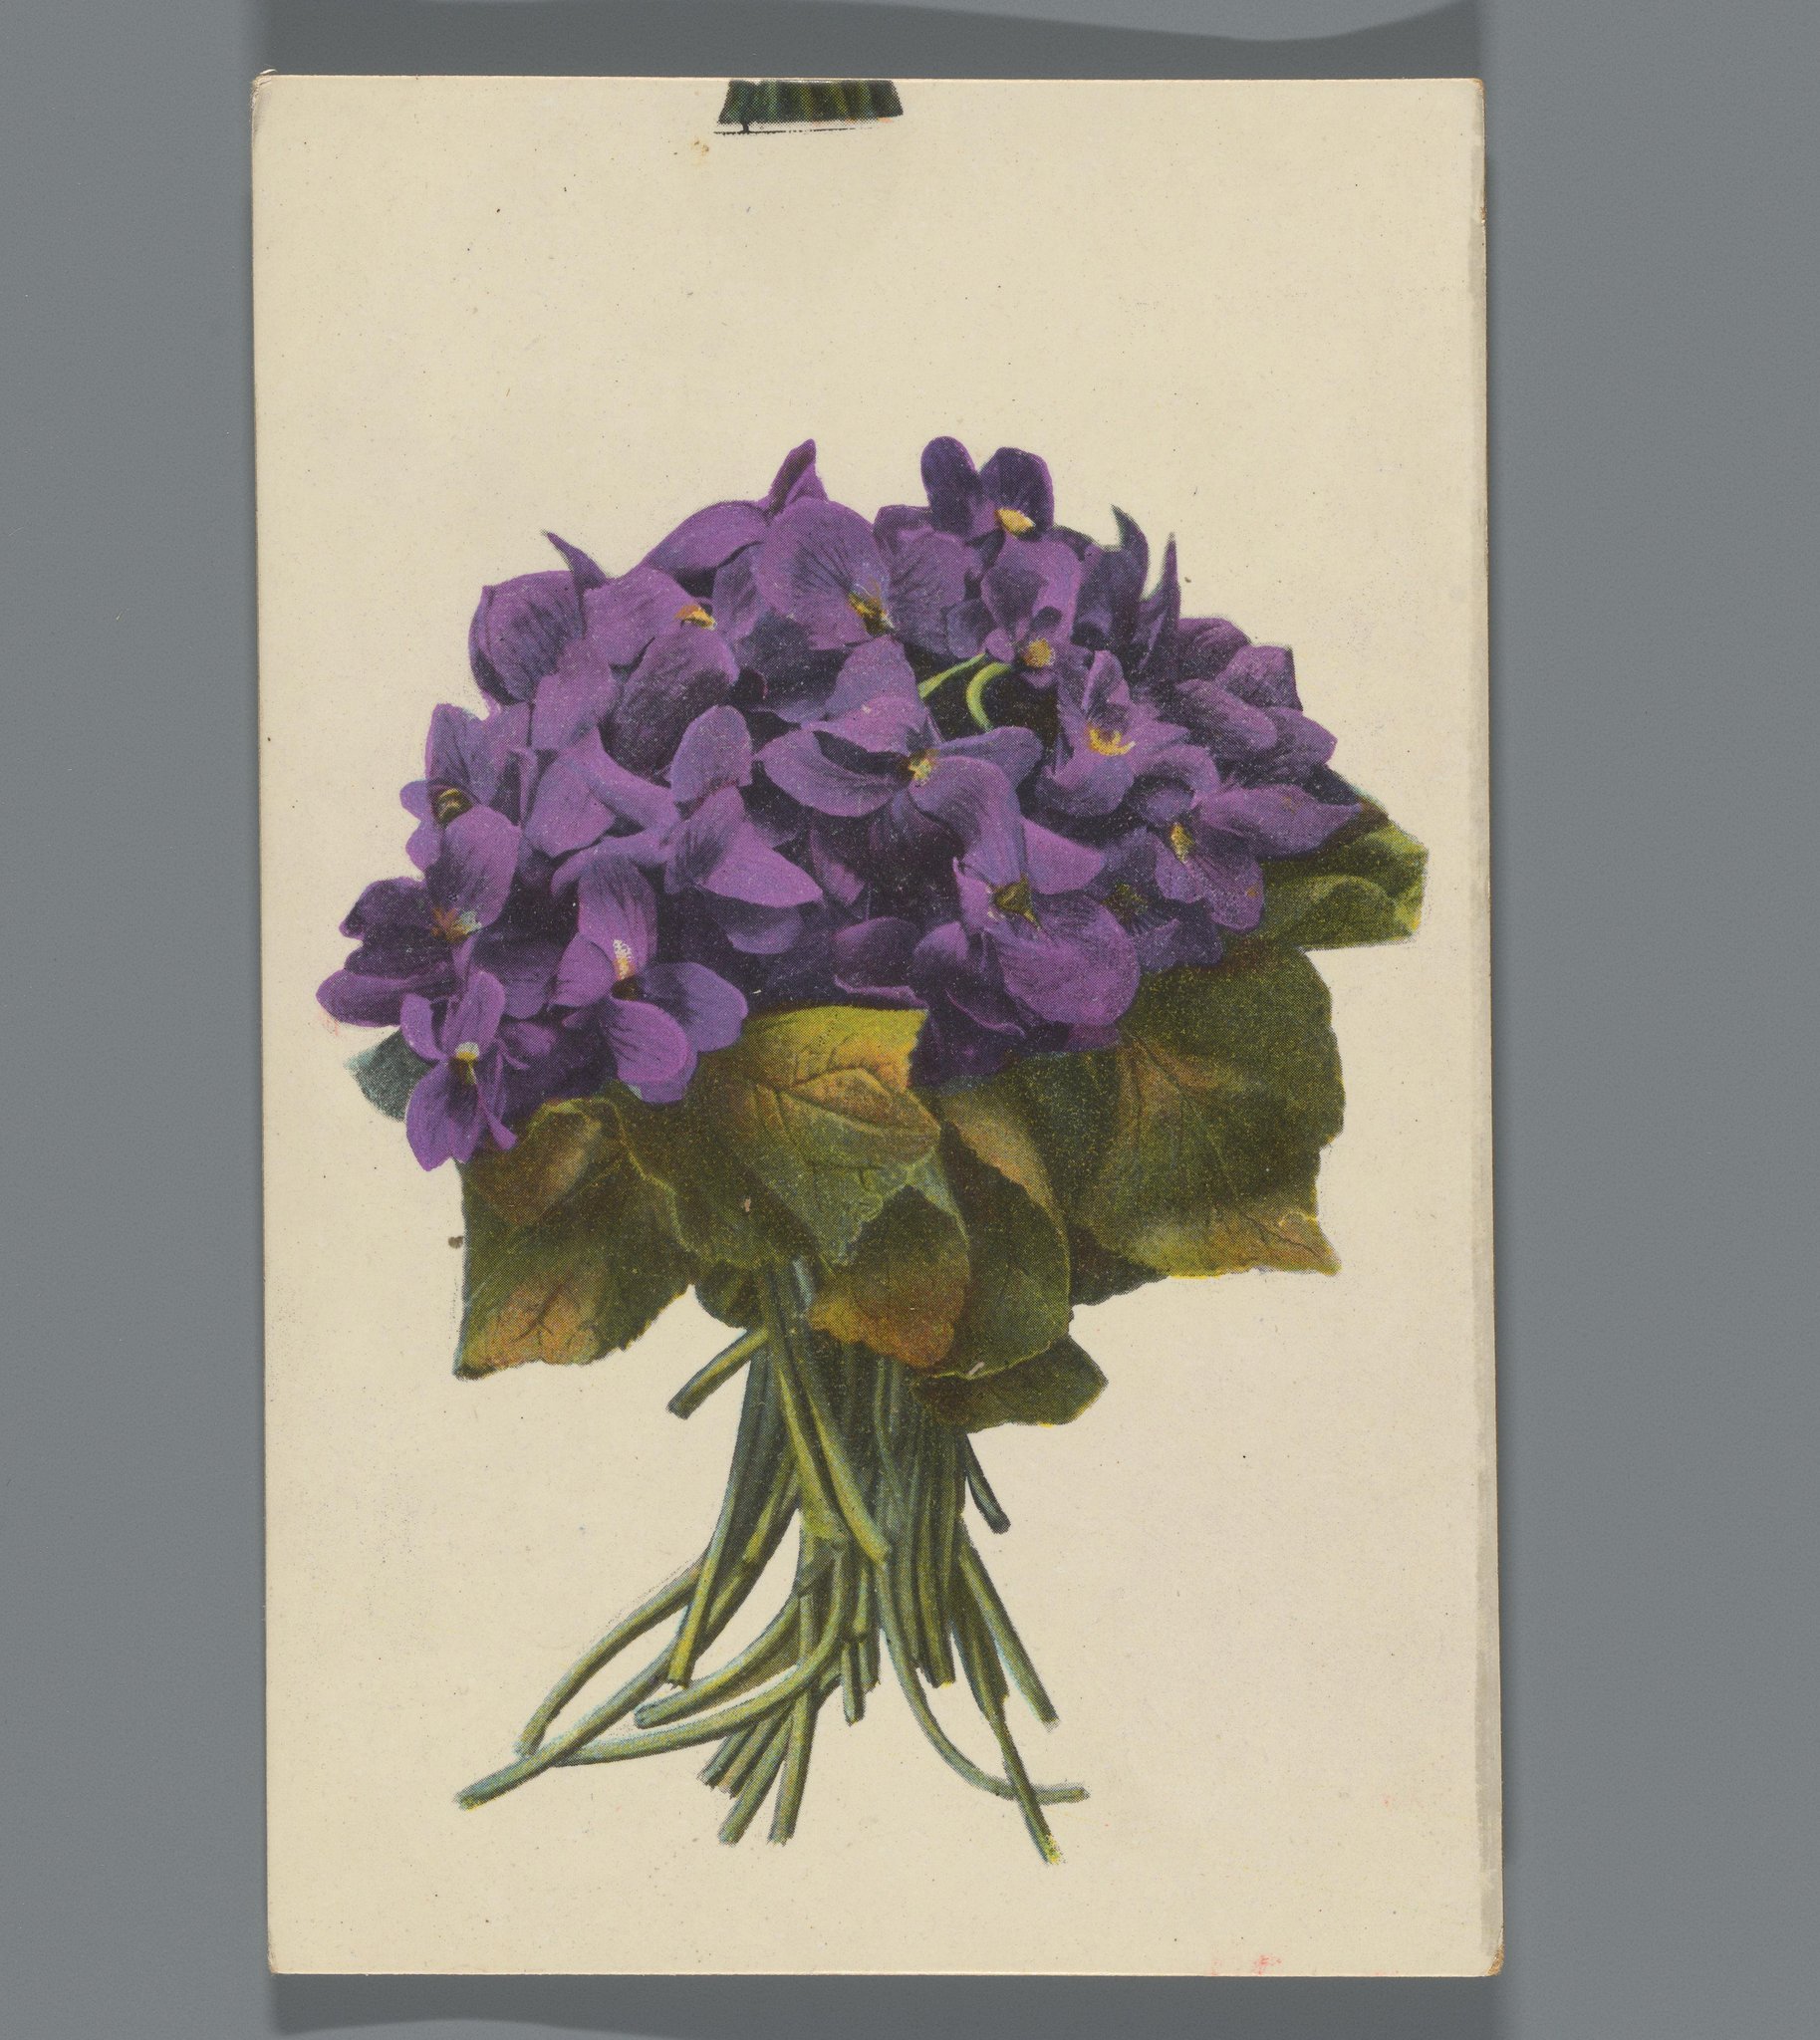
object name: ansichtkaart, prentbriefkaart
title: Boeket bloemen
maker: Anonymous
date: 1905-1910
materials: paper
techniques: lithograph, writing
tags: flowers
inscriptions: inscription: ‘Anna van Aalst/ Johannahof/ Ophemert/ Willem van Bergen/ Gasthuisstraat D 93/ Tiel’, number: ‘Serie 2151. 3./ 10791’